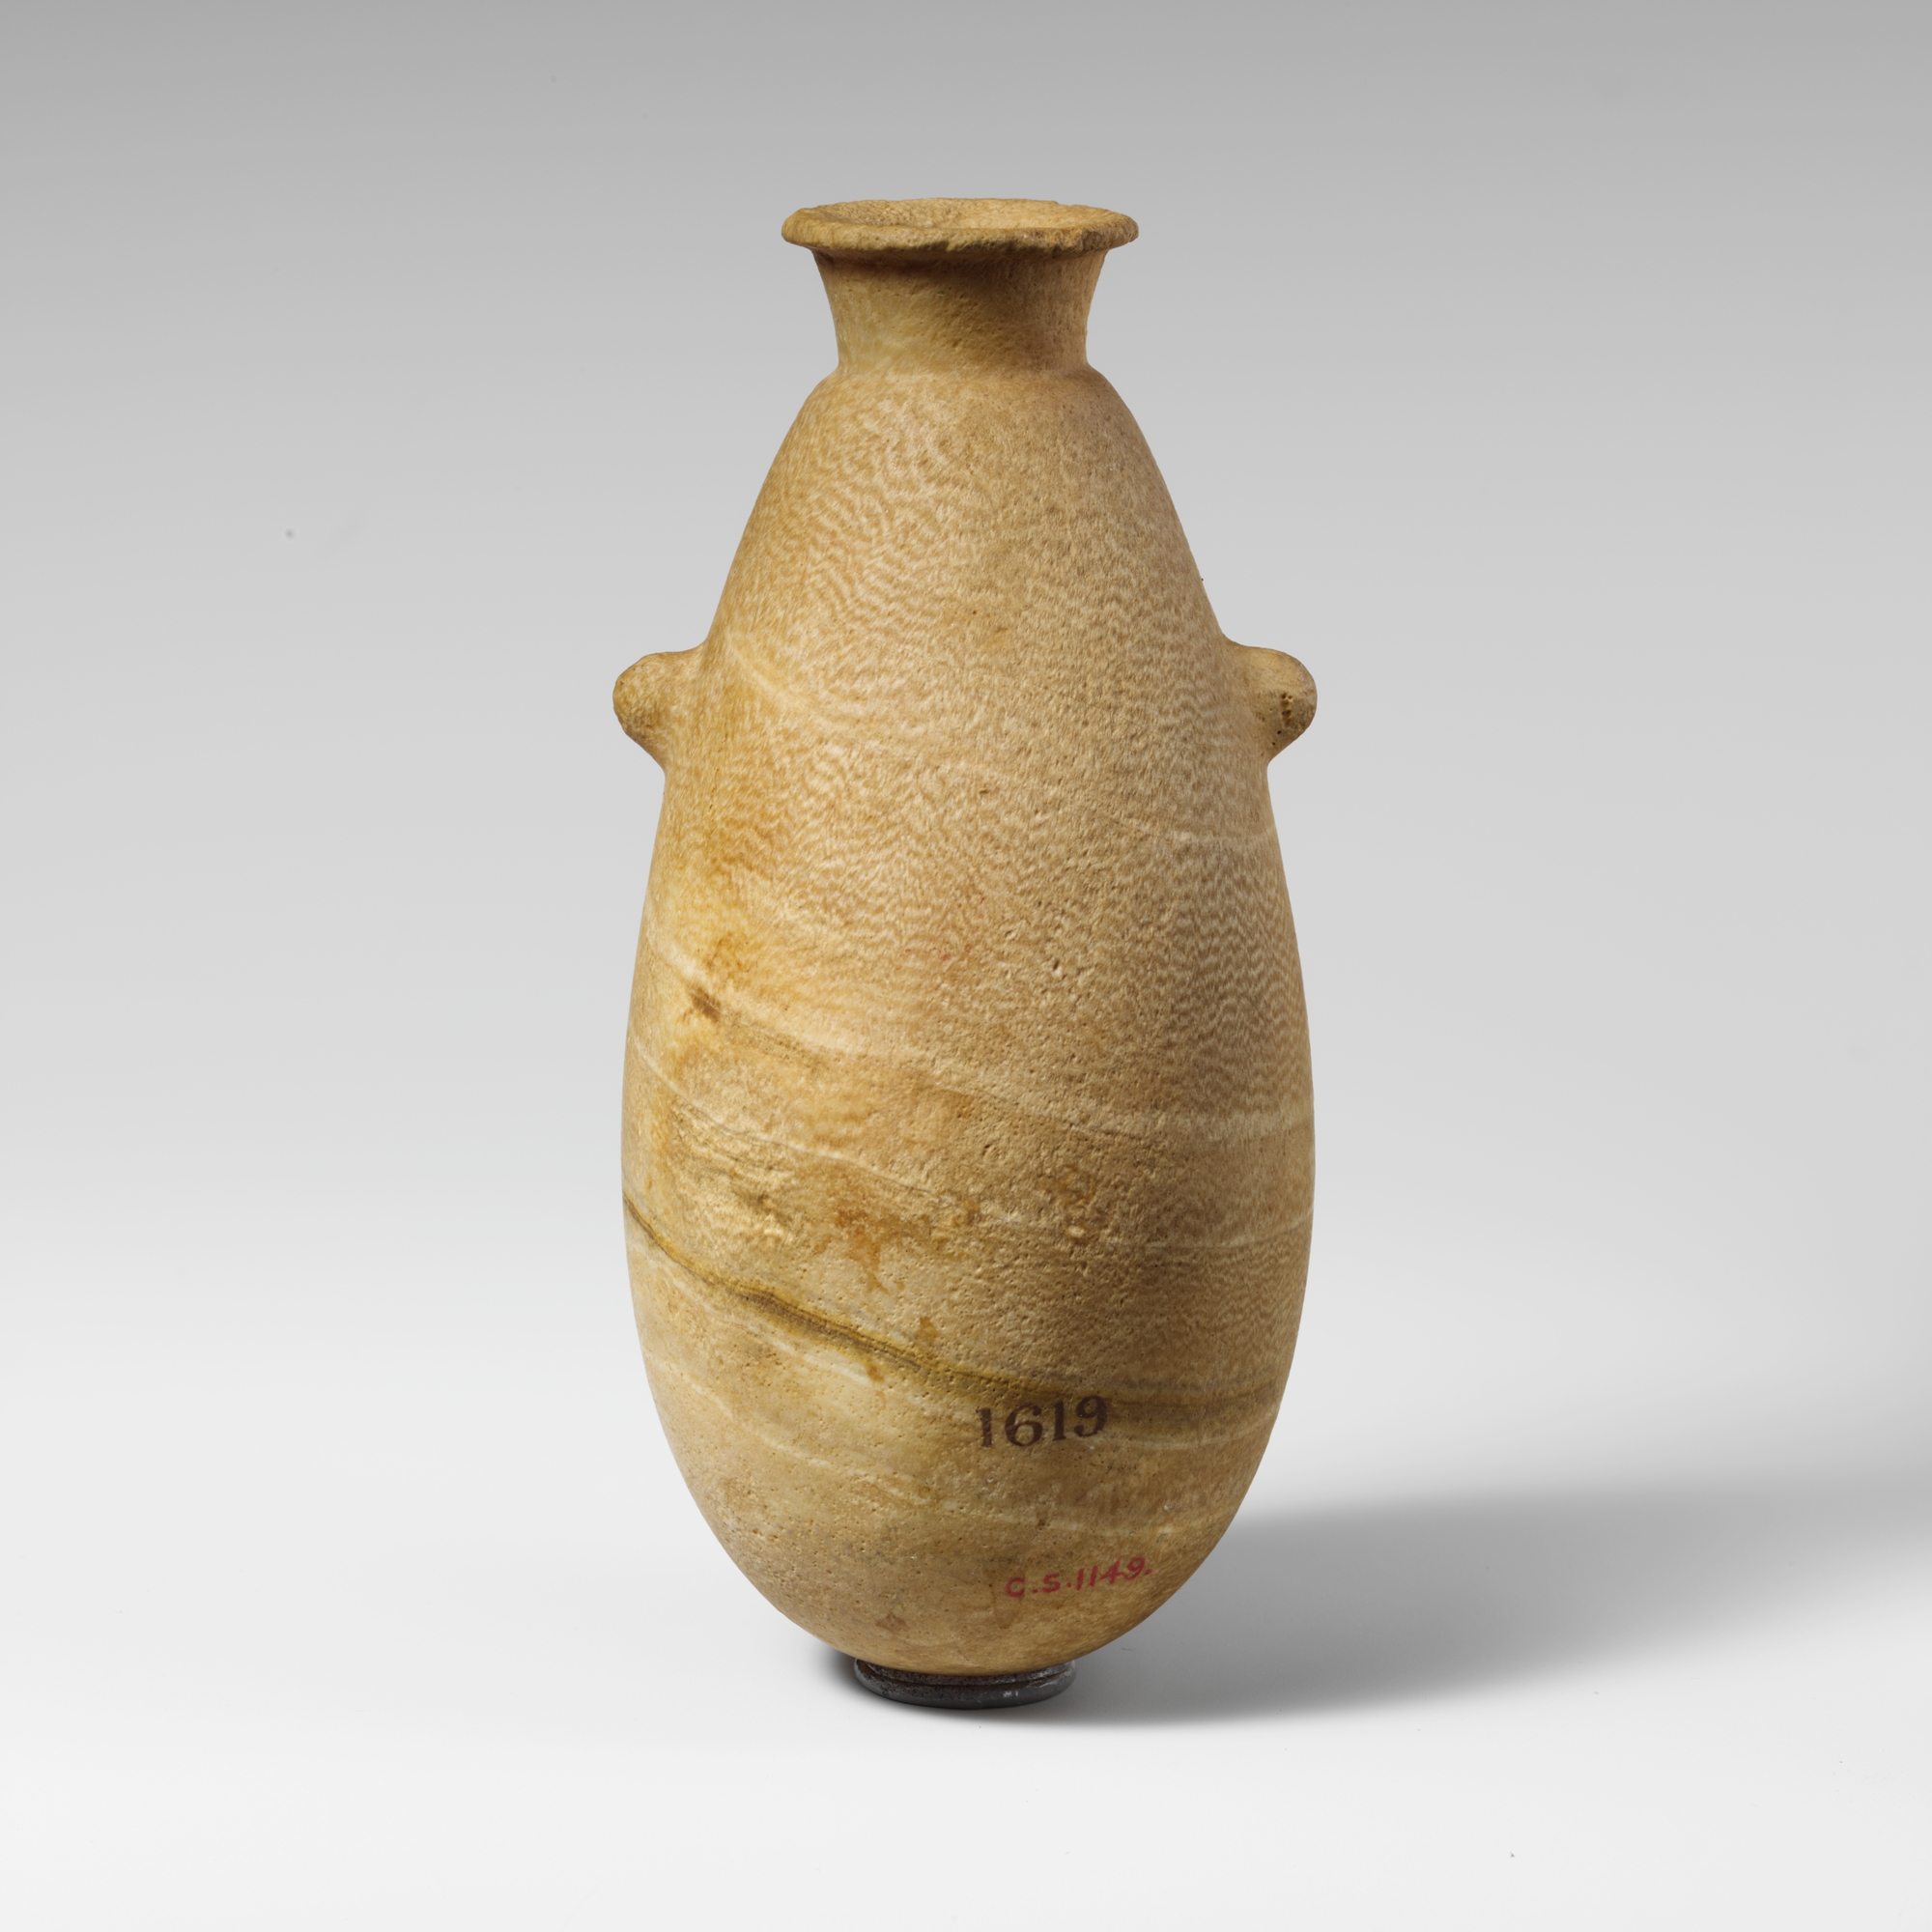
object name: alabastron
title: Alabaster alabastron (perfume vase)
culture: cypriot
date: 600-401 BCE